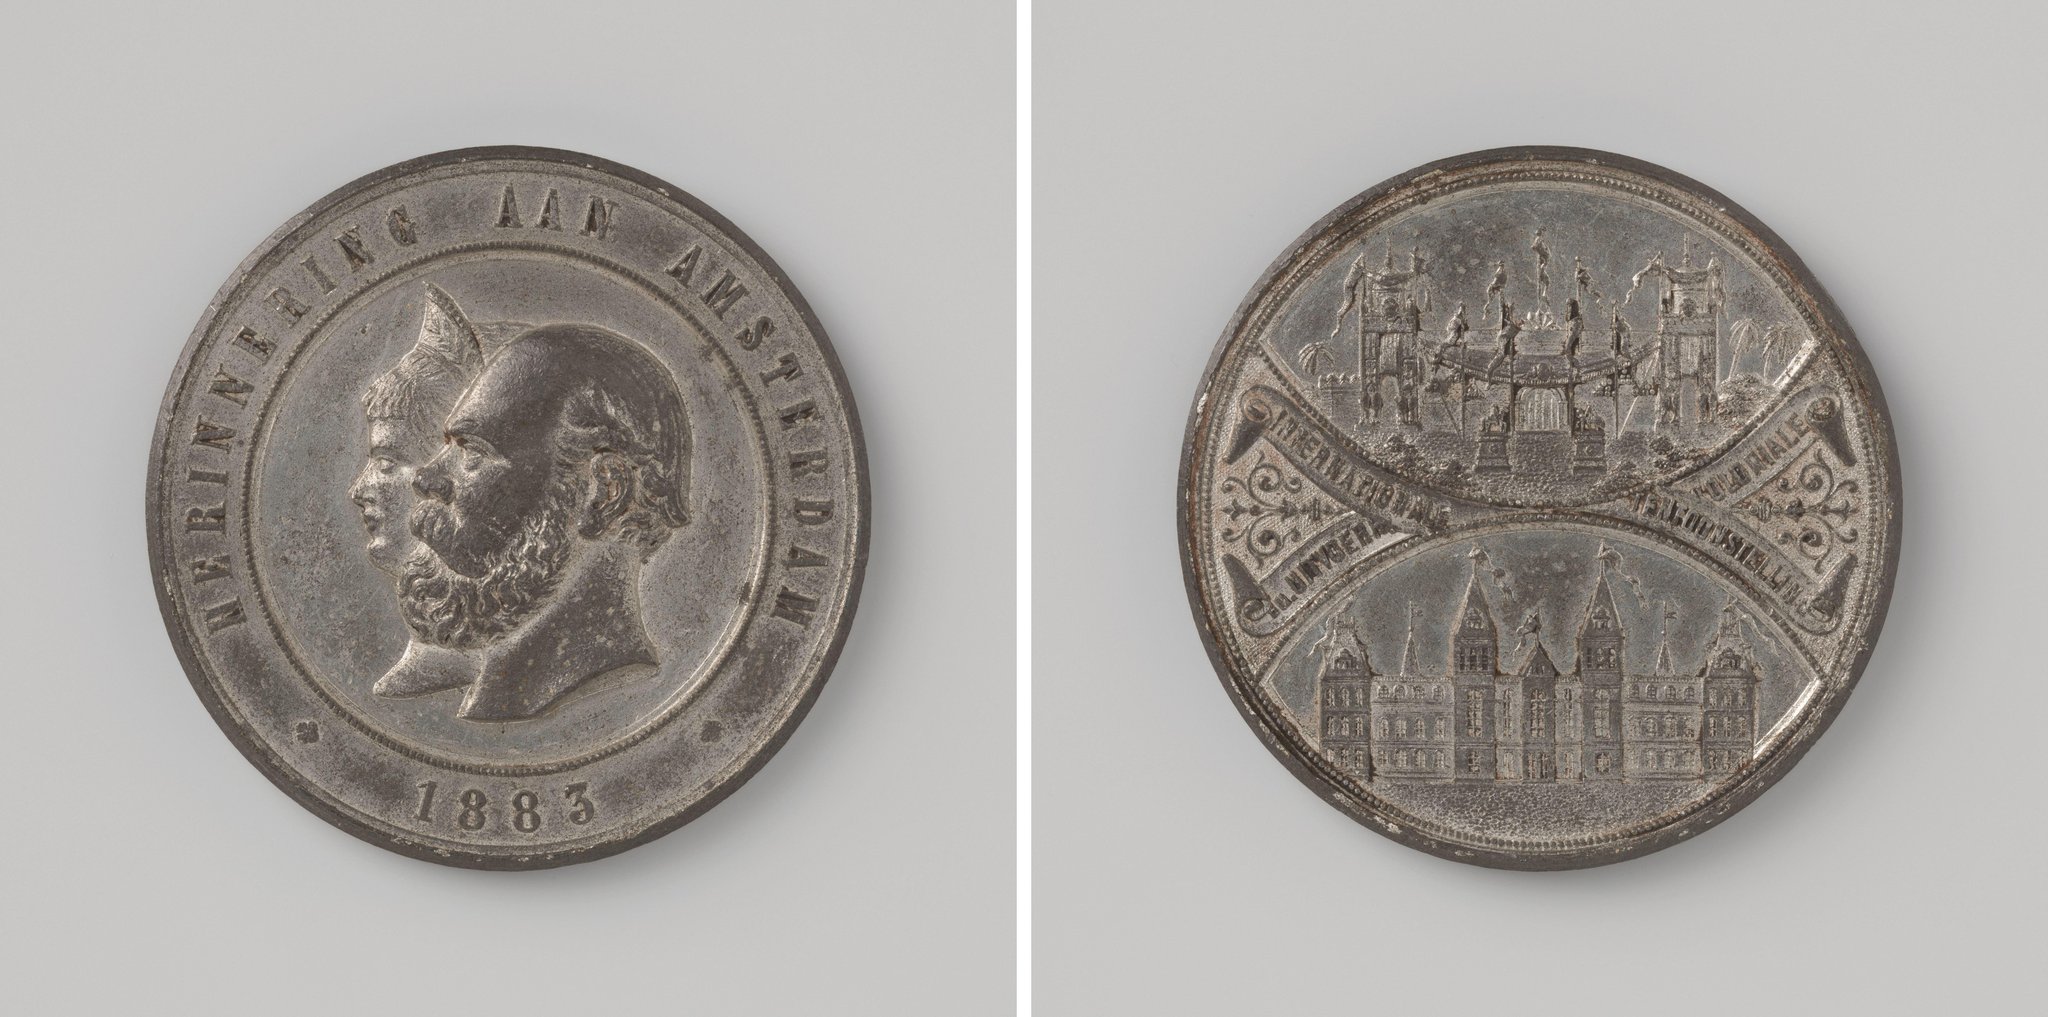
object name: history medal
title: Internationale Koloniale en Uitvoerhandel-tentoonstelling te Amsterdam 1883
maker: e. mayer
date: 1883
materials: tin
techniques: striking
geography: stuttgart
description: Tinnen penning, op de voorzijde de geconjugeerde portretten van Koning Willem III en Koningin Emma naar links met omschrift, op de keerzijde boven elkaar twee ellipsvormige medaillons met het tentoonstellingsgebouw en het Rijksmuseum, waartussen een versierde ruimte met twee kruisende tekstlinten.